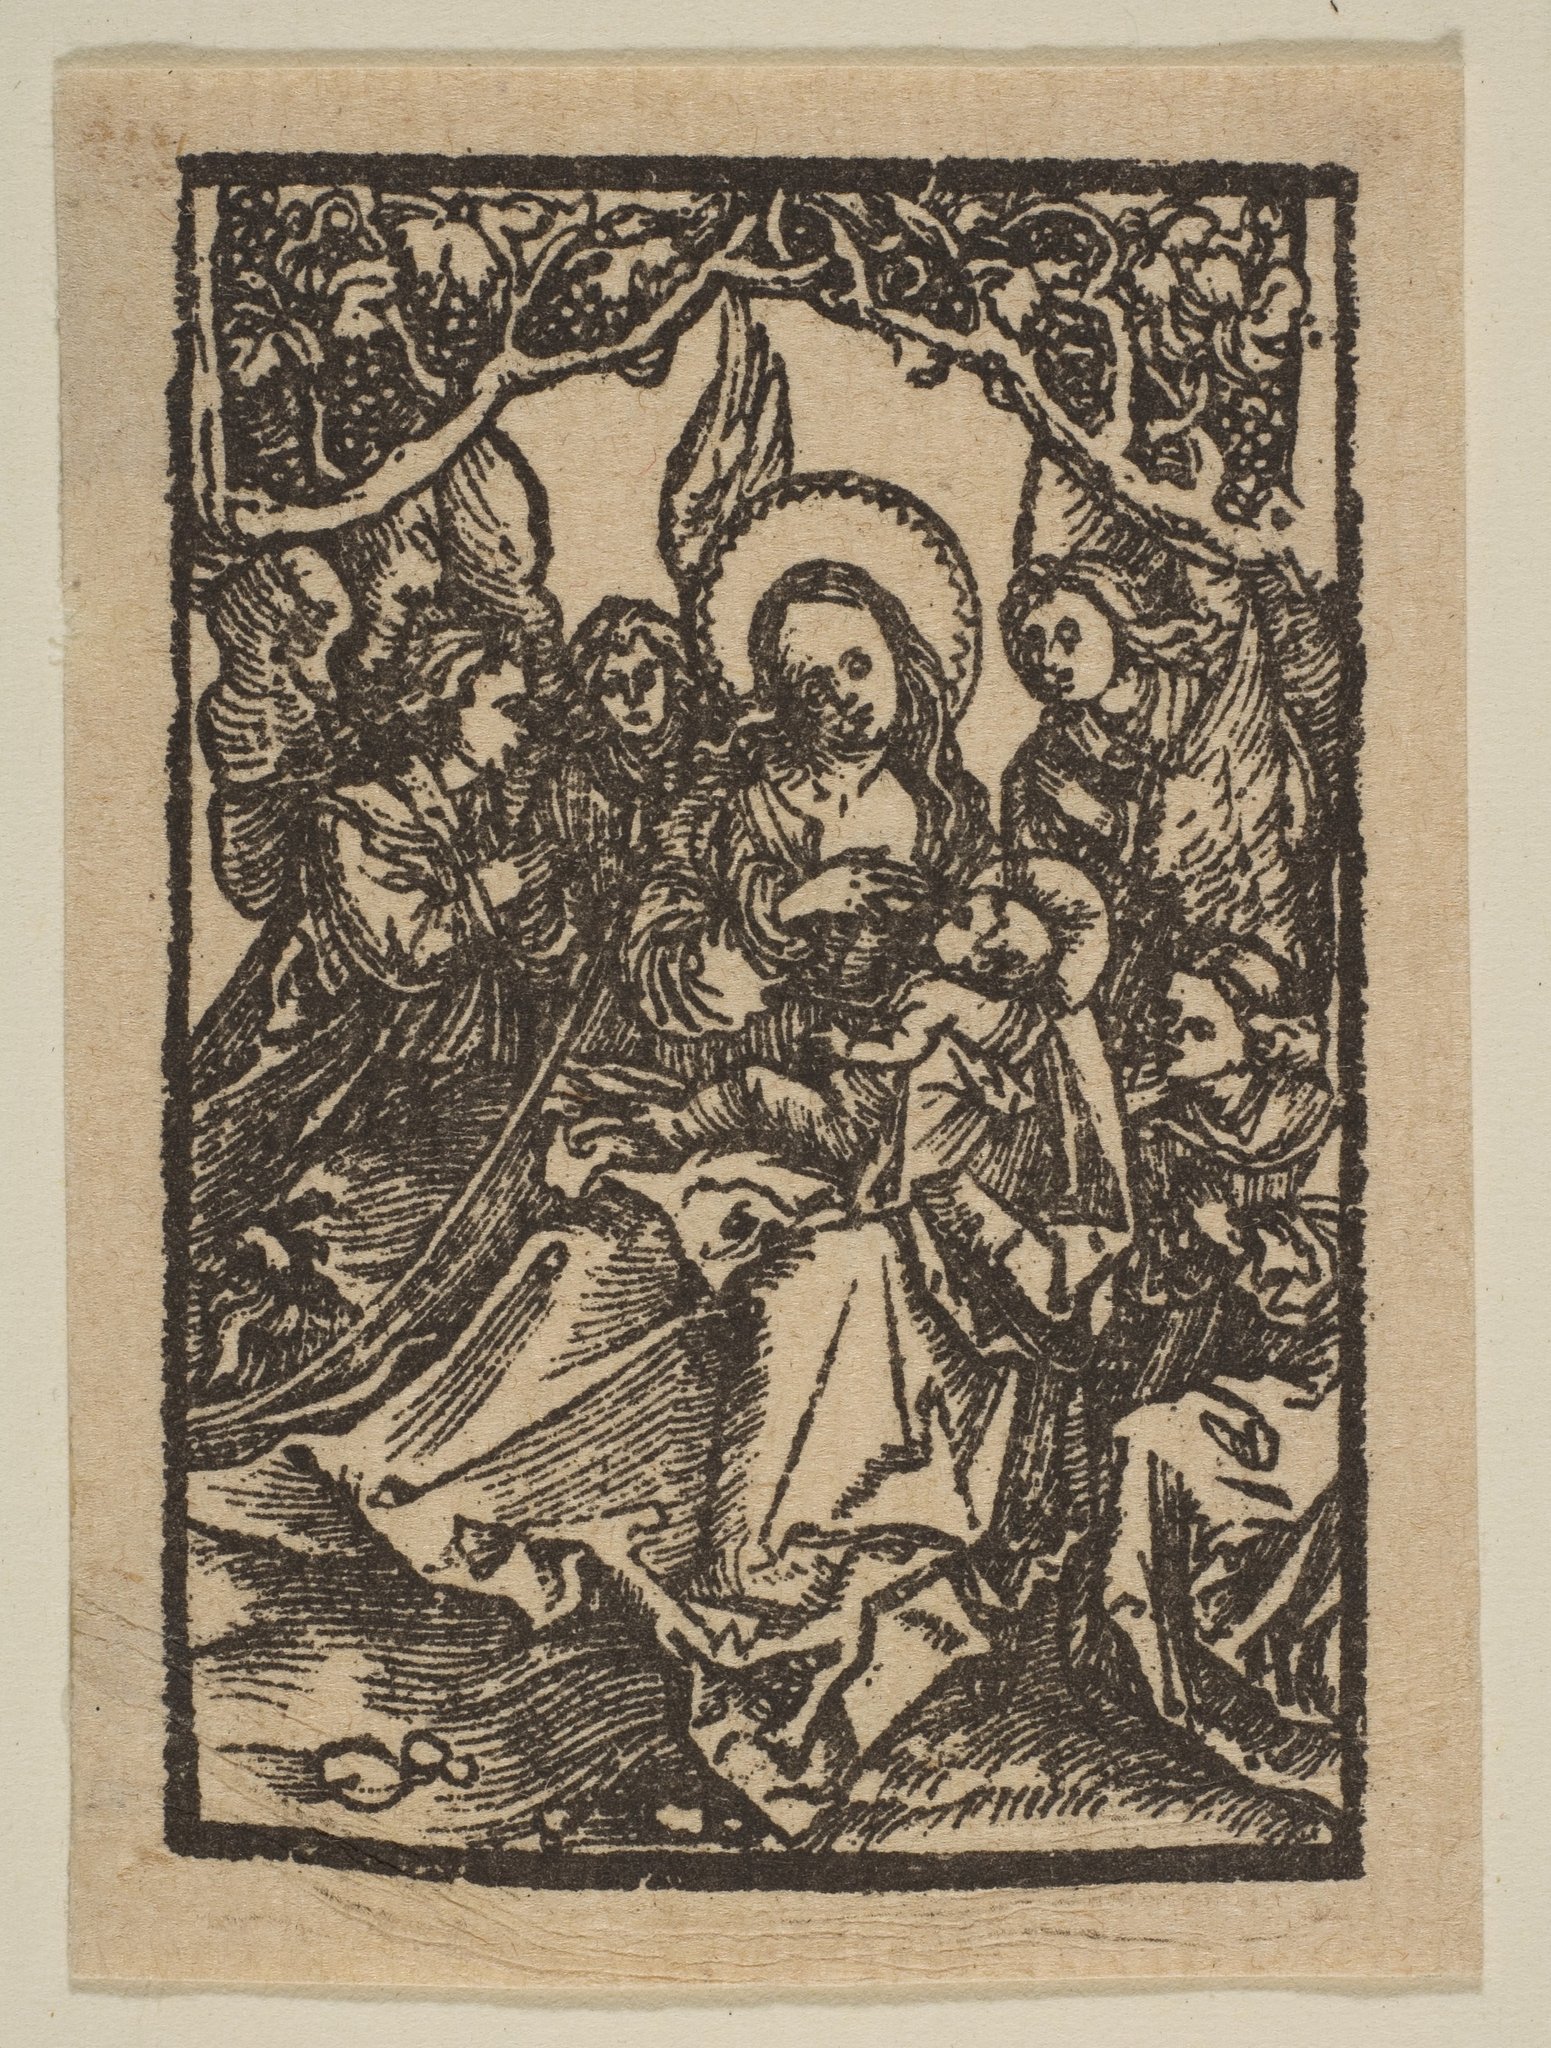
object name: print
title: The Virgin and the Child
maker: albrecht dürer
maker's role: artist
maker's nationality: german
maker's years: 1471-1528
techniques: woodcut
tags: angels,madonna and child